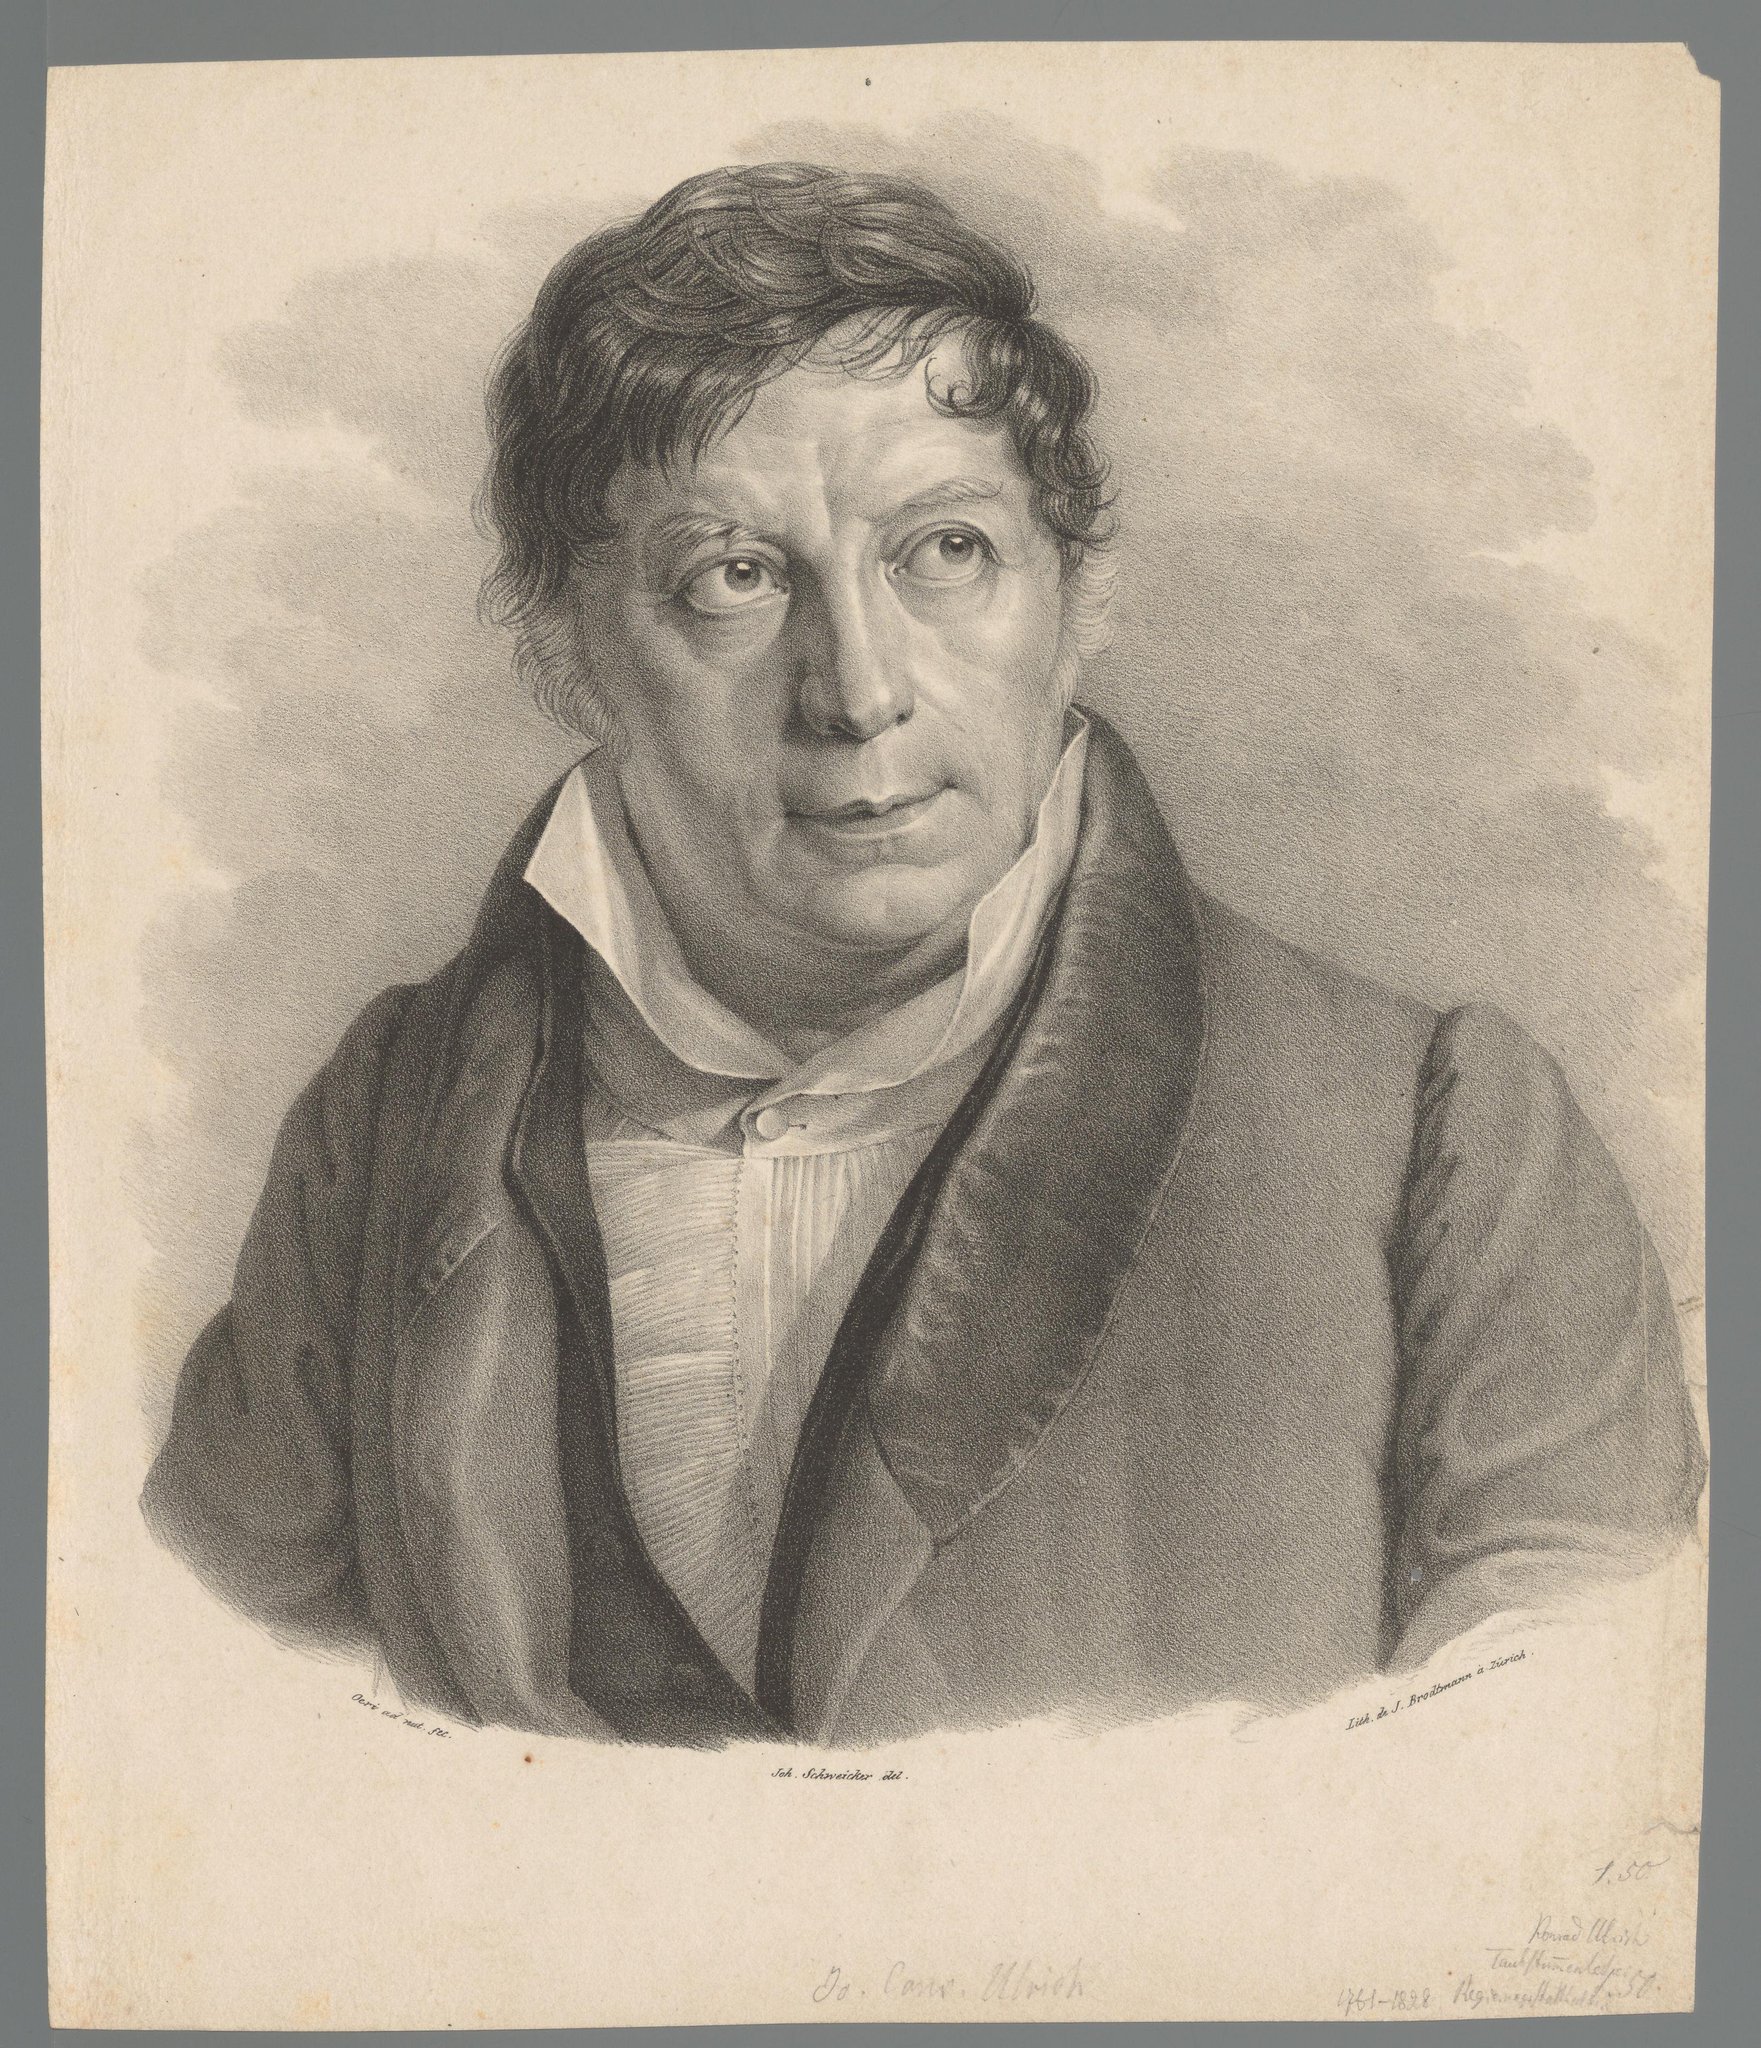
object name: print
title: Portret van Johann Konrad Ulrich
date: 1815-1850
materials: paper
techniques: lithograph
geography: zurich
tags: adult man, historical persons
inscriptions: collector's mark: Lugt 2228